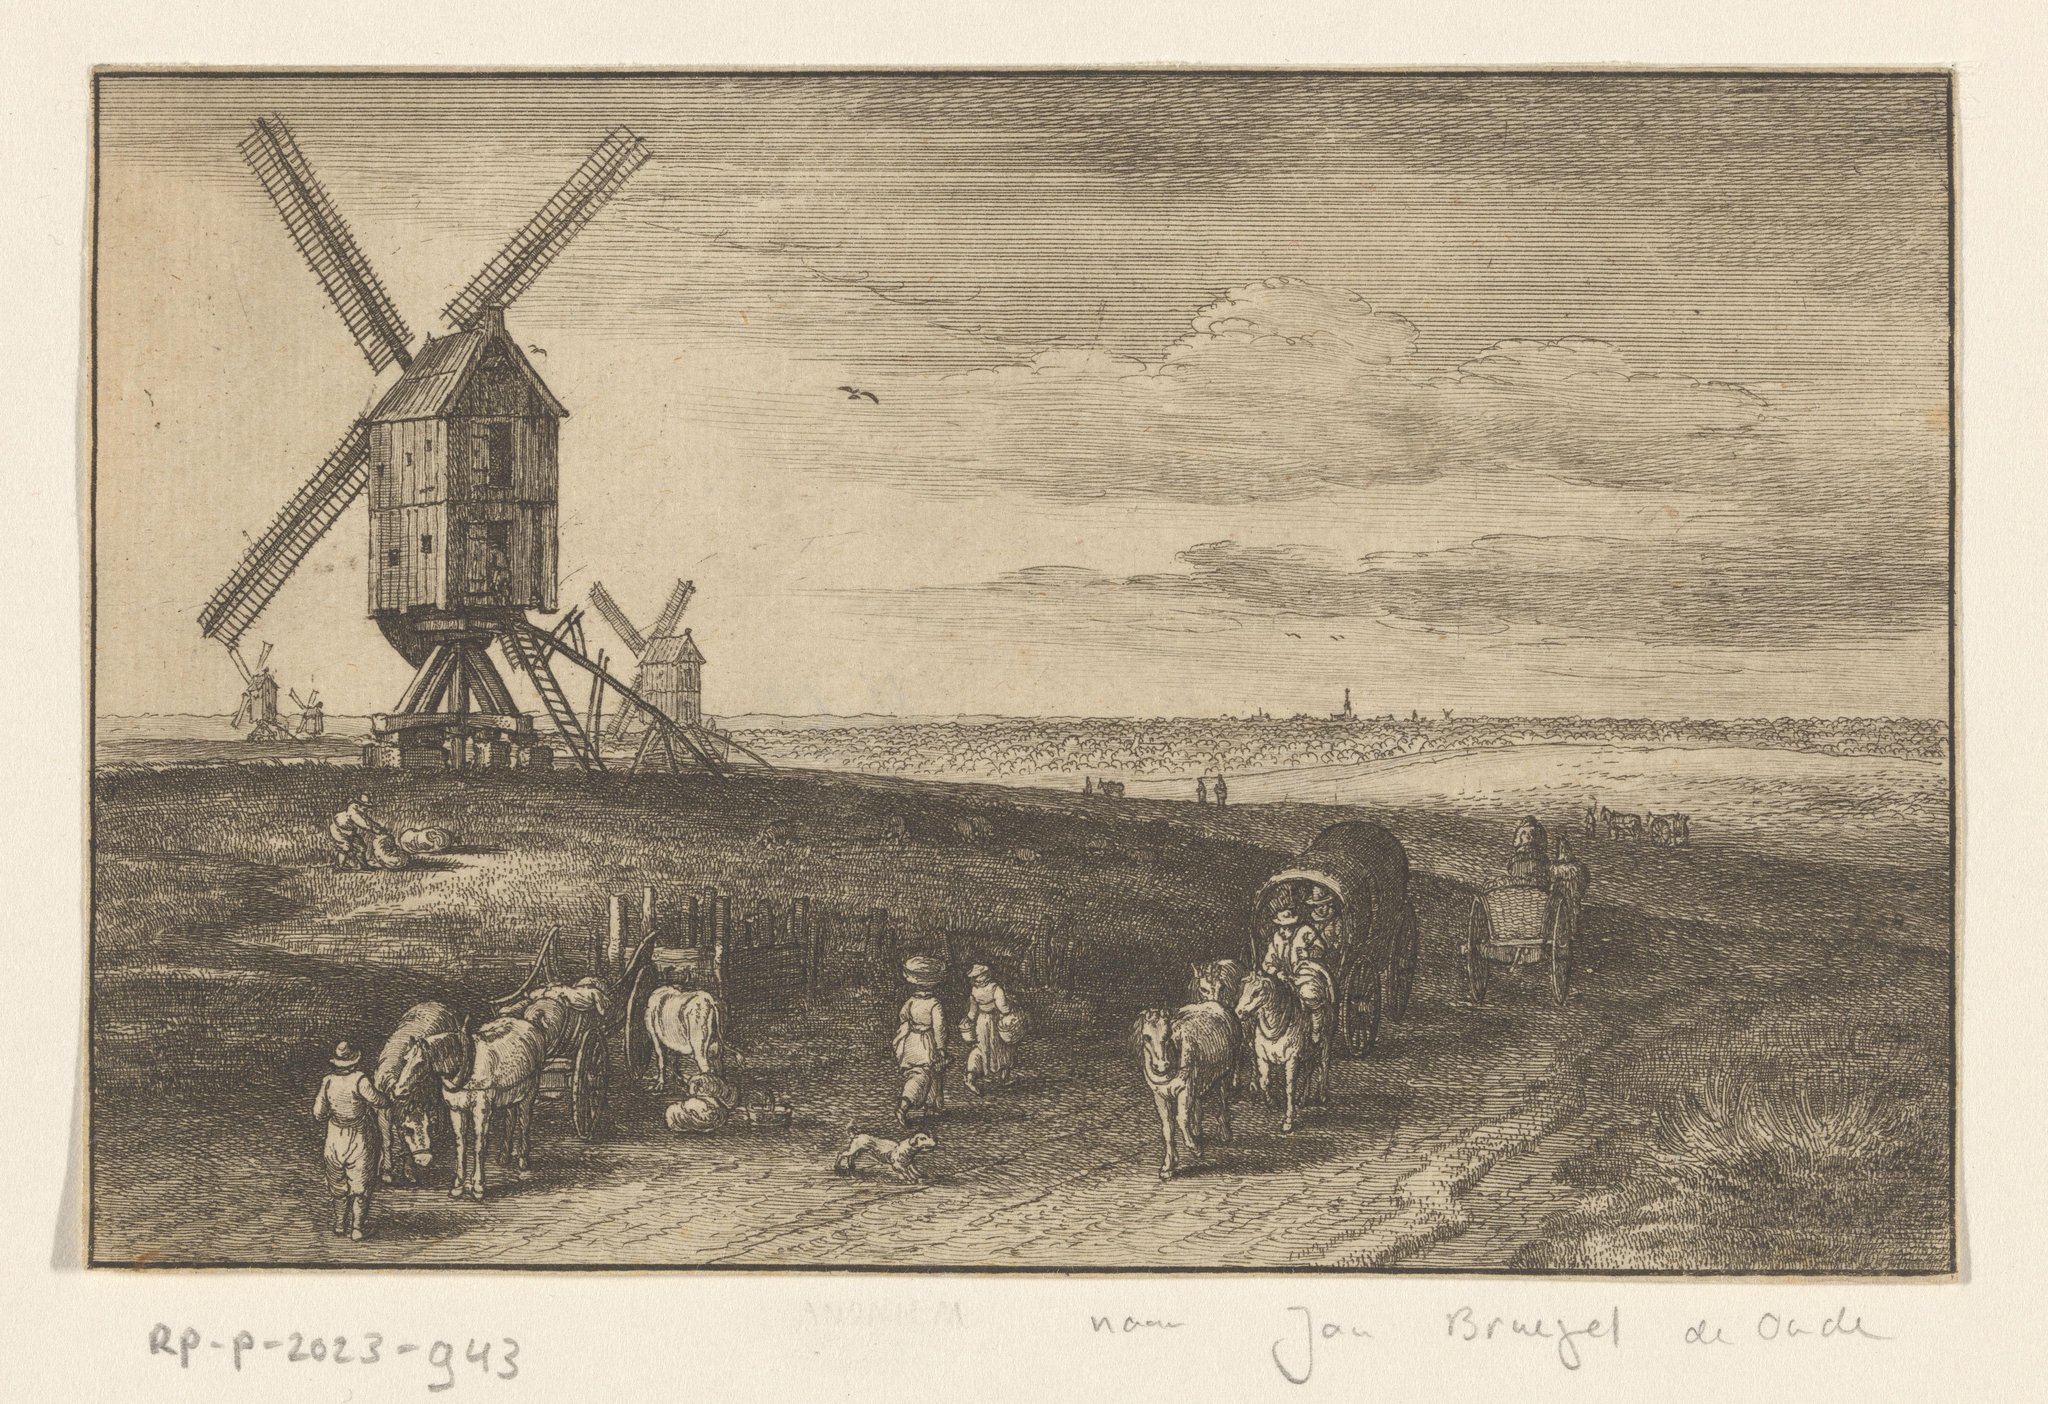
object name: print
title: Landschap met vier windmolens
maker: wenceslaus hollar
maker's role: draughtsman, print maker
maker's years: 1607-1677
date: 1650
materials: paper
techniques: drypoint, etching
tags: four-wheeled vehicle drawn by three animals, windmill in landscape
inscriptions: collector's mark: Lugt 2228